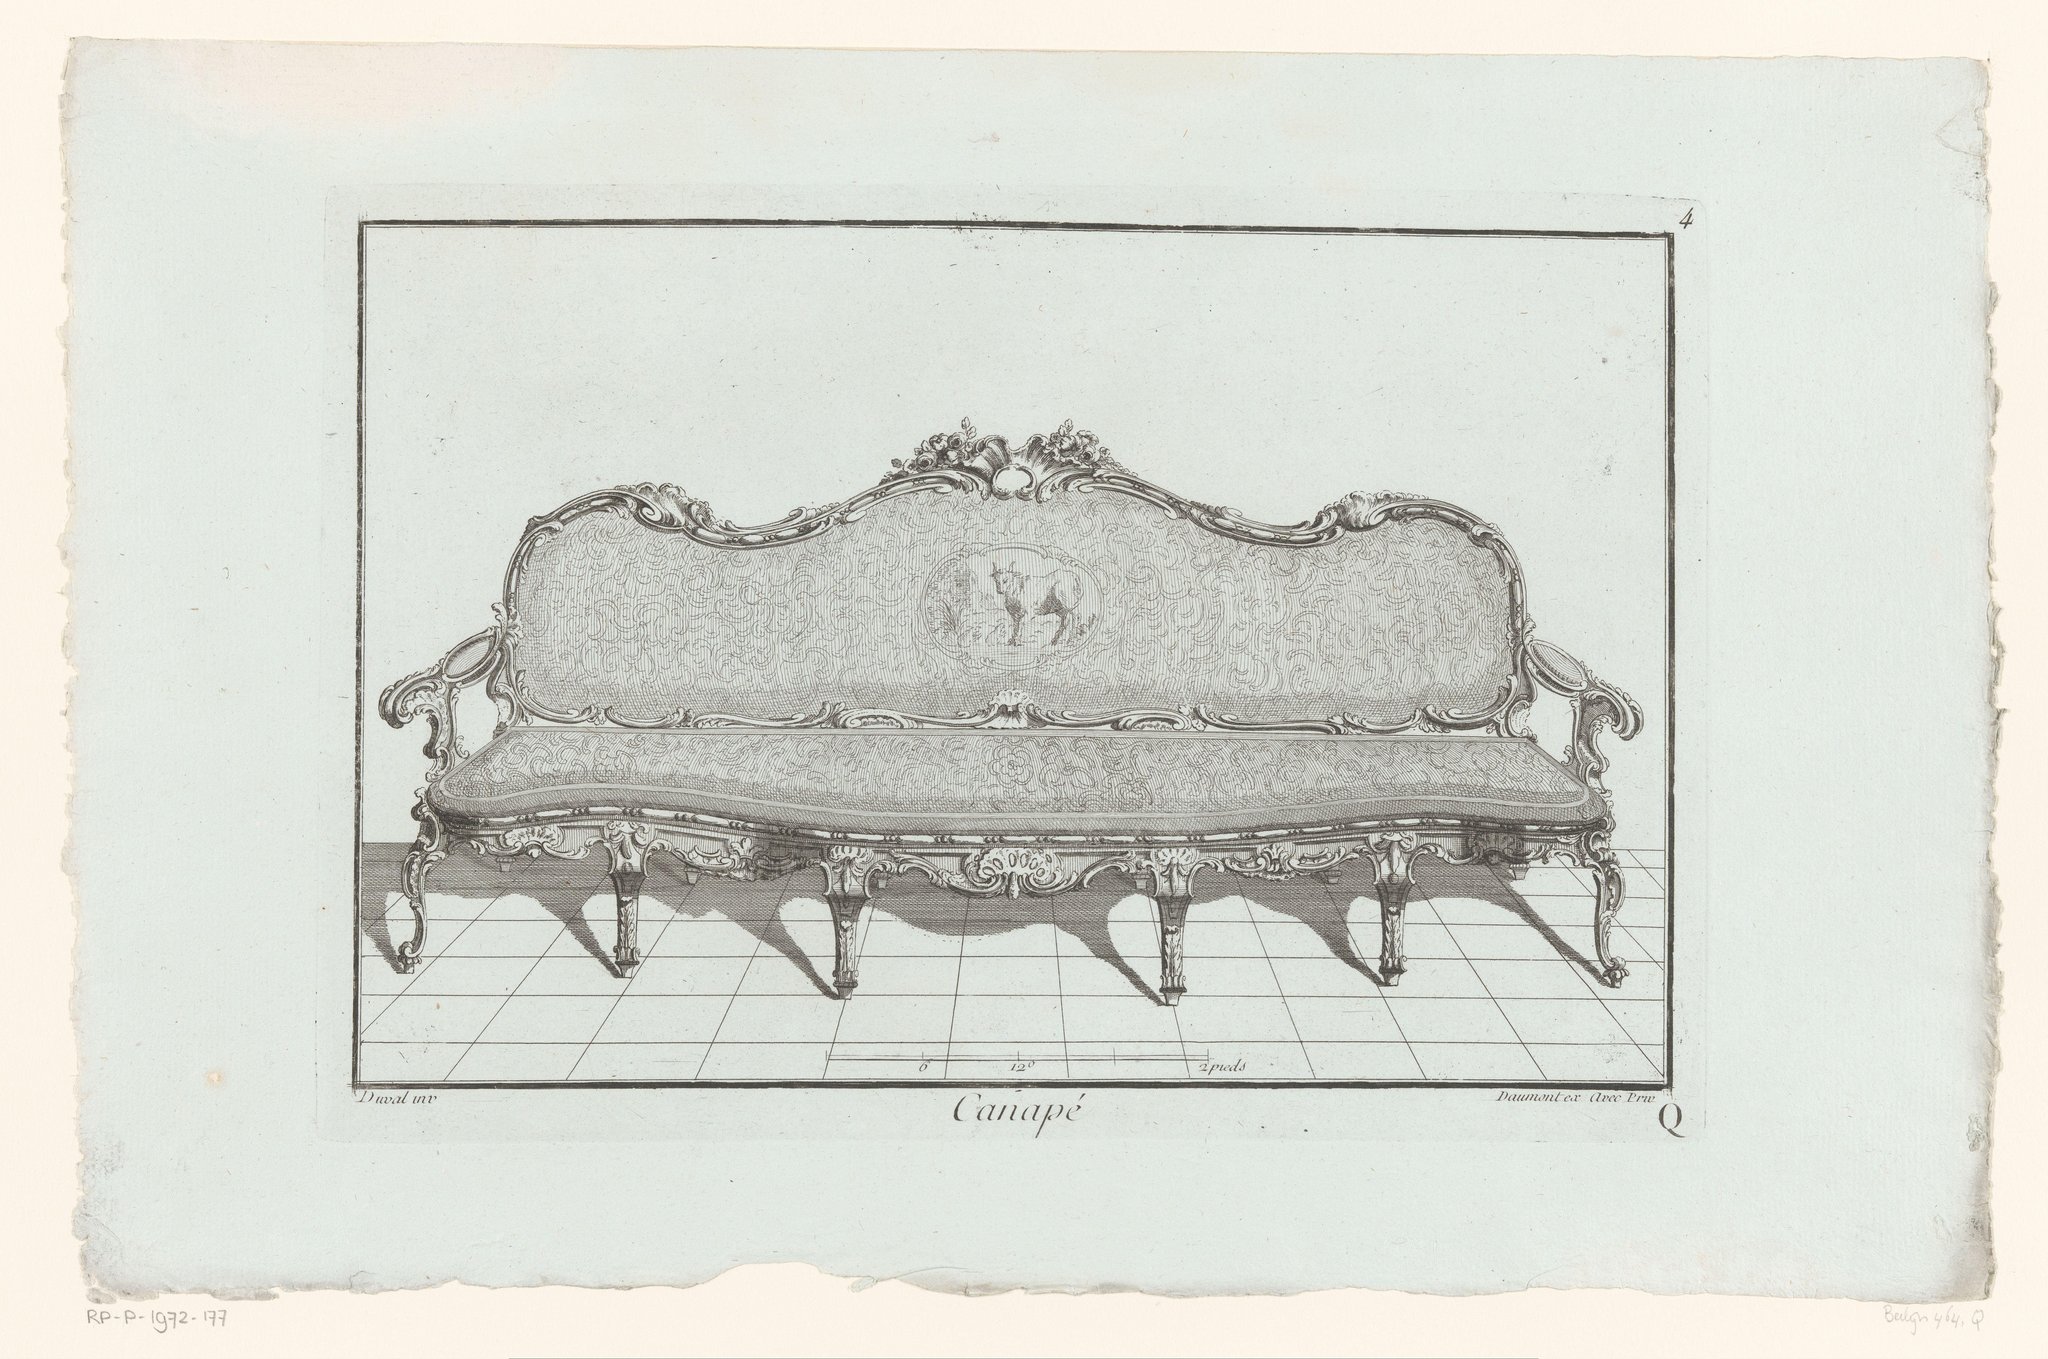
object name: ornament print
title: Canapé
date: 1745-1775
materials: paper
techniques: engraving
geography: paris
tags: couch, sofa, settee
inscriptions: collector's mark: Lugt 2228, collector's mark: Lugt 2760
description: Een bank met armleuningen en bekleding met bloemmotieven en een rund, geornamenteerd met rocailles.